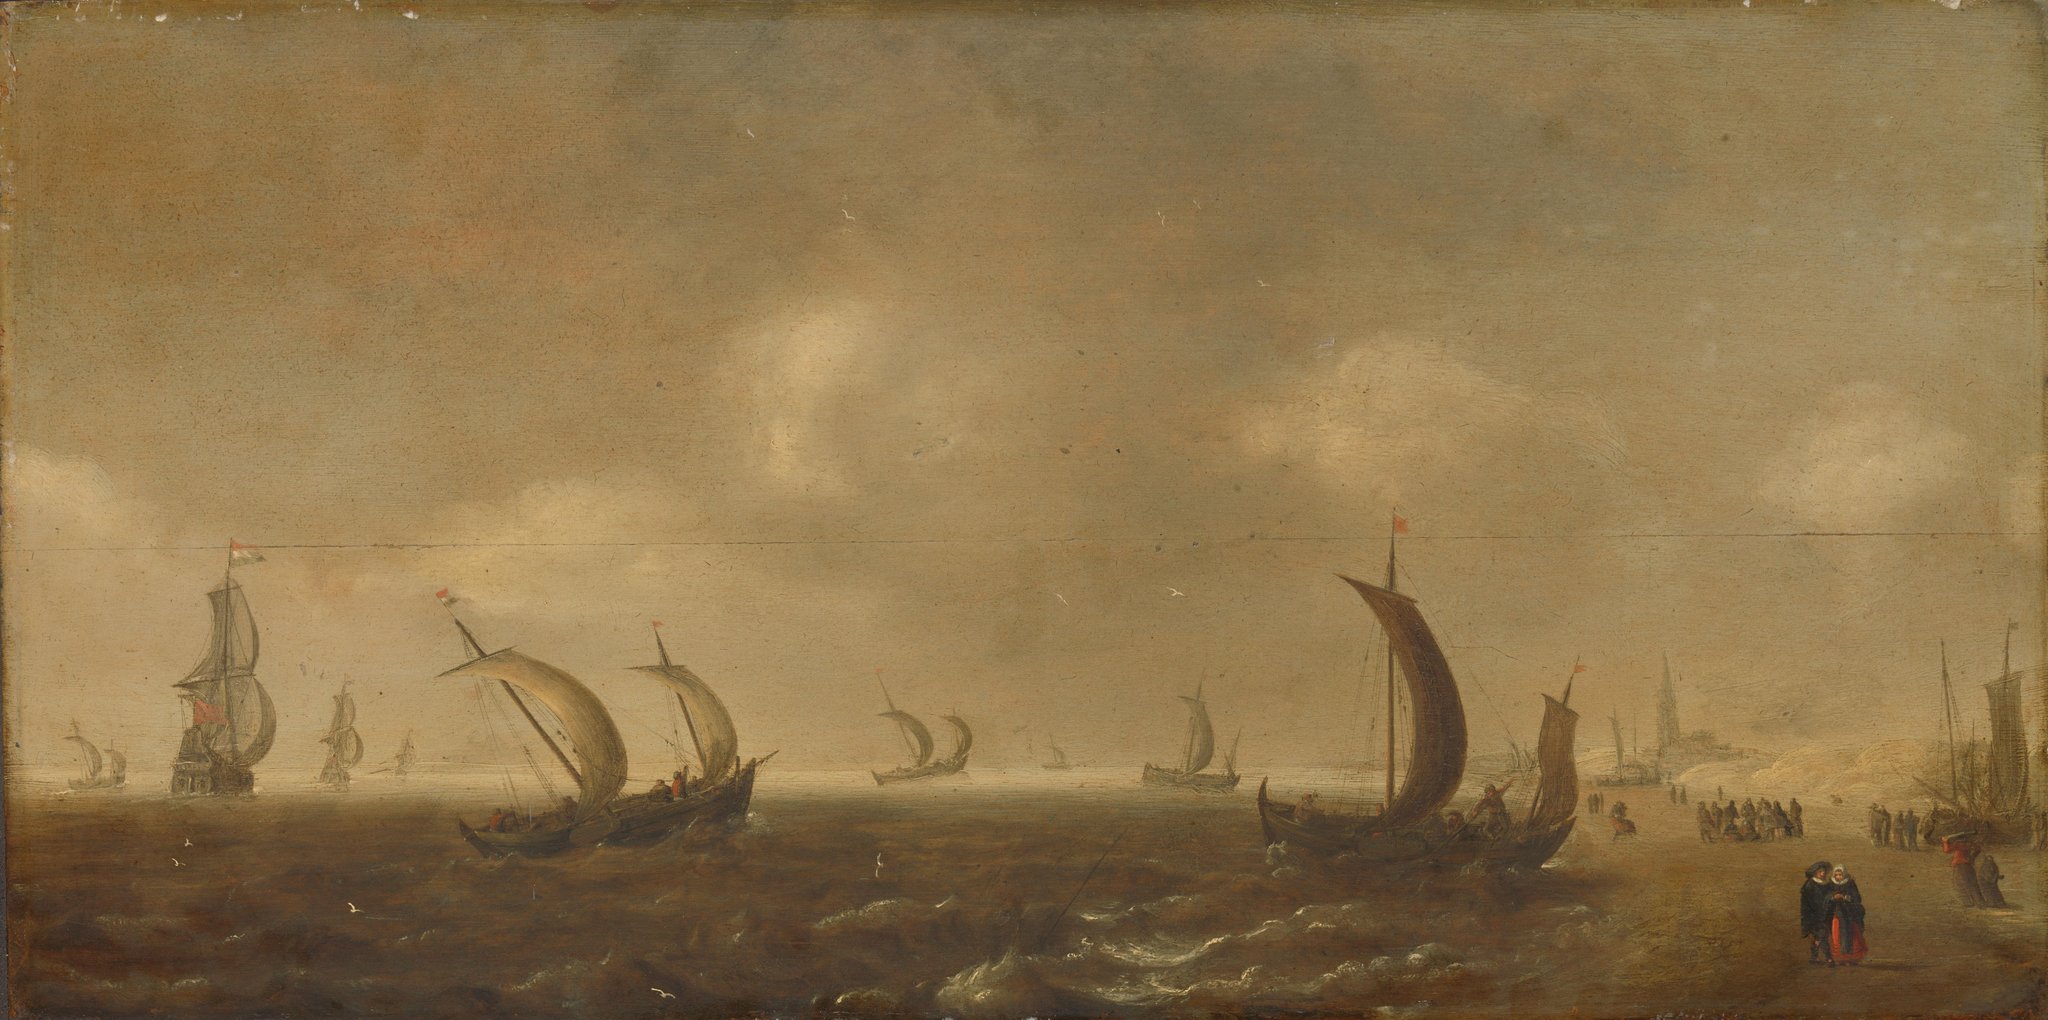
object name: painting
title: Seascape on the Beach at Scheveningen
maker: willem van diest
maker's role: painter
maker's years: 1610-1668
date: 1629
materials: oil, panel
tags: sailing-ship, sailing-boat, sea (seascape), beach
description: Zeegezicht aan het strand te Scheveningen. Rechts vissers en wandelaars op het strand, links vissersschepen in het water.